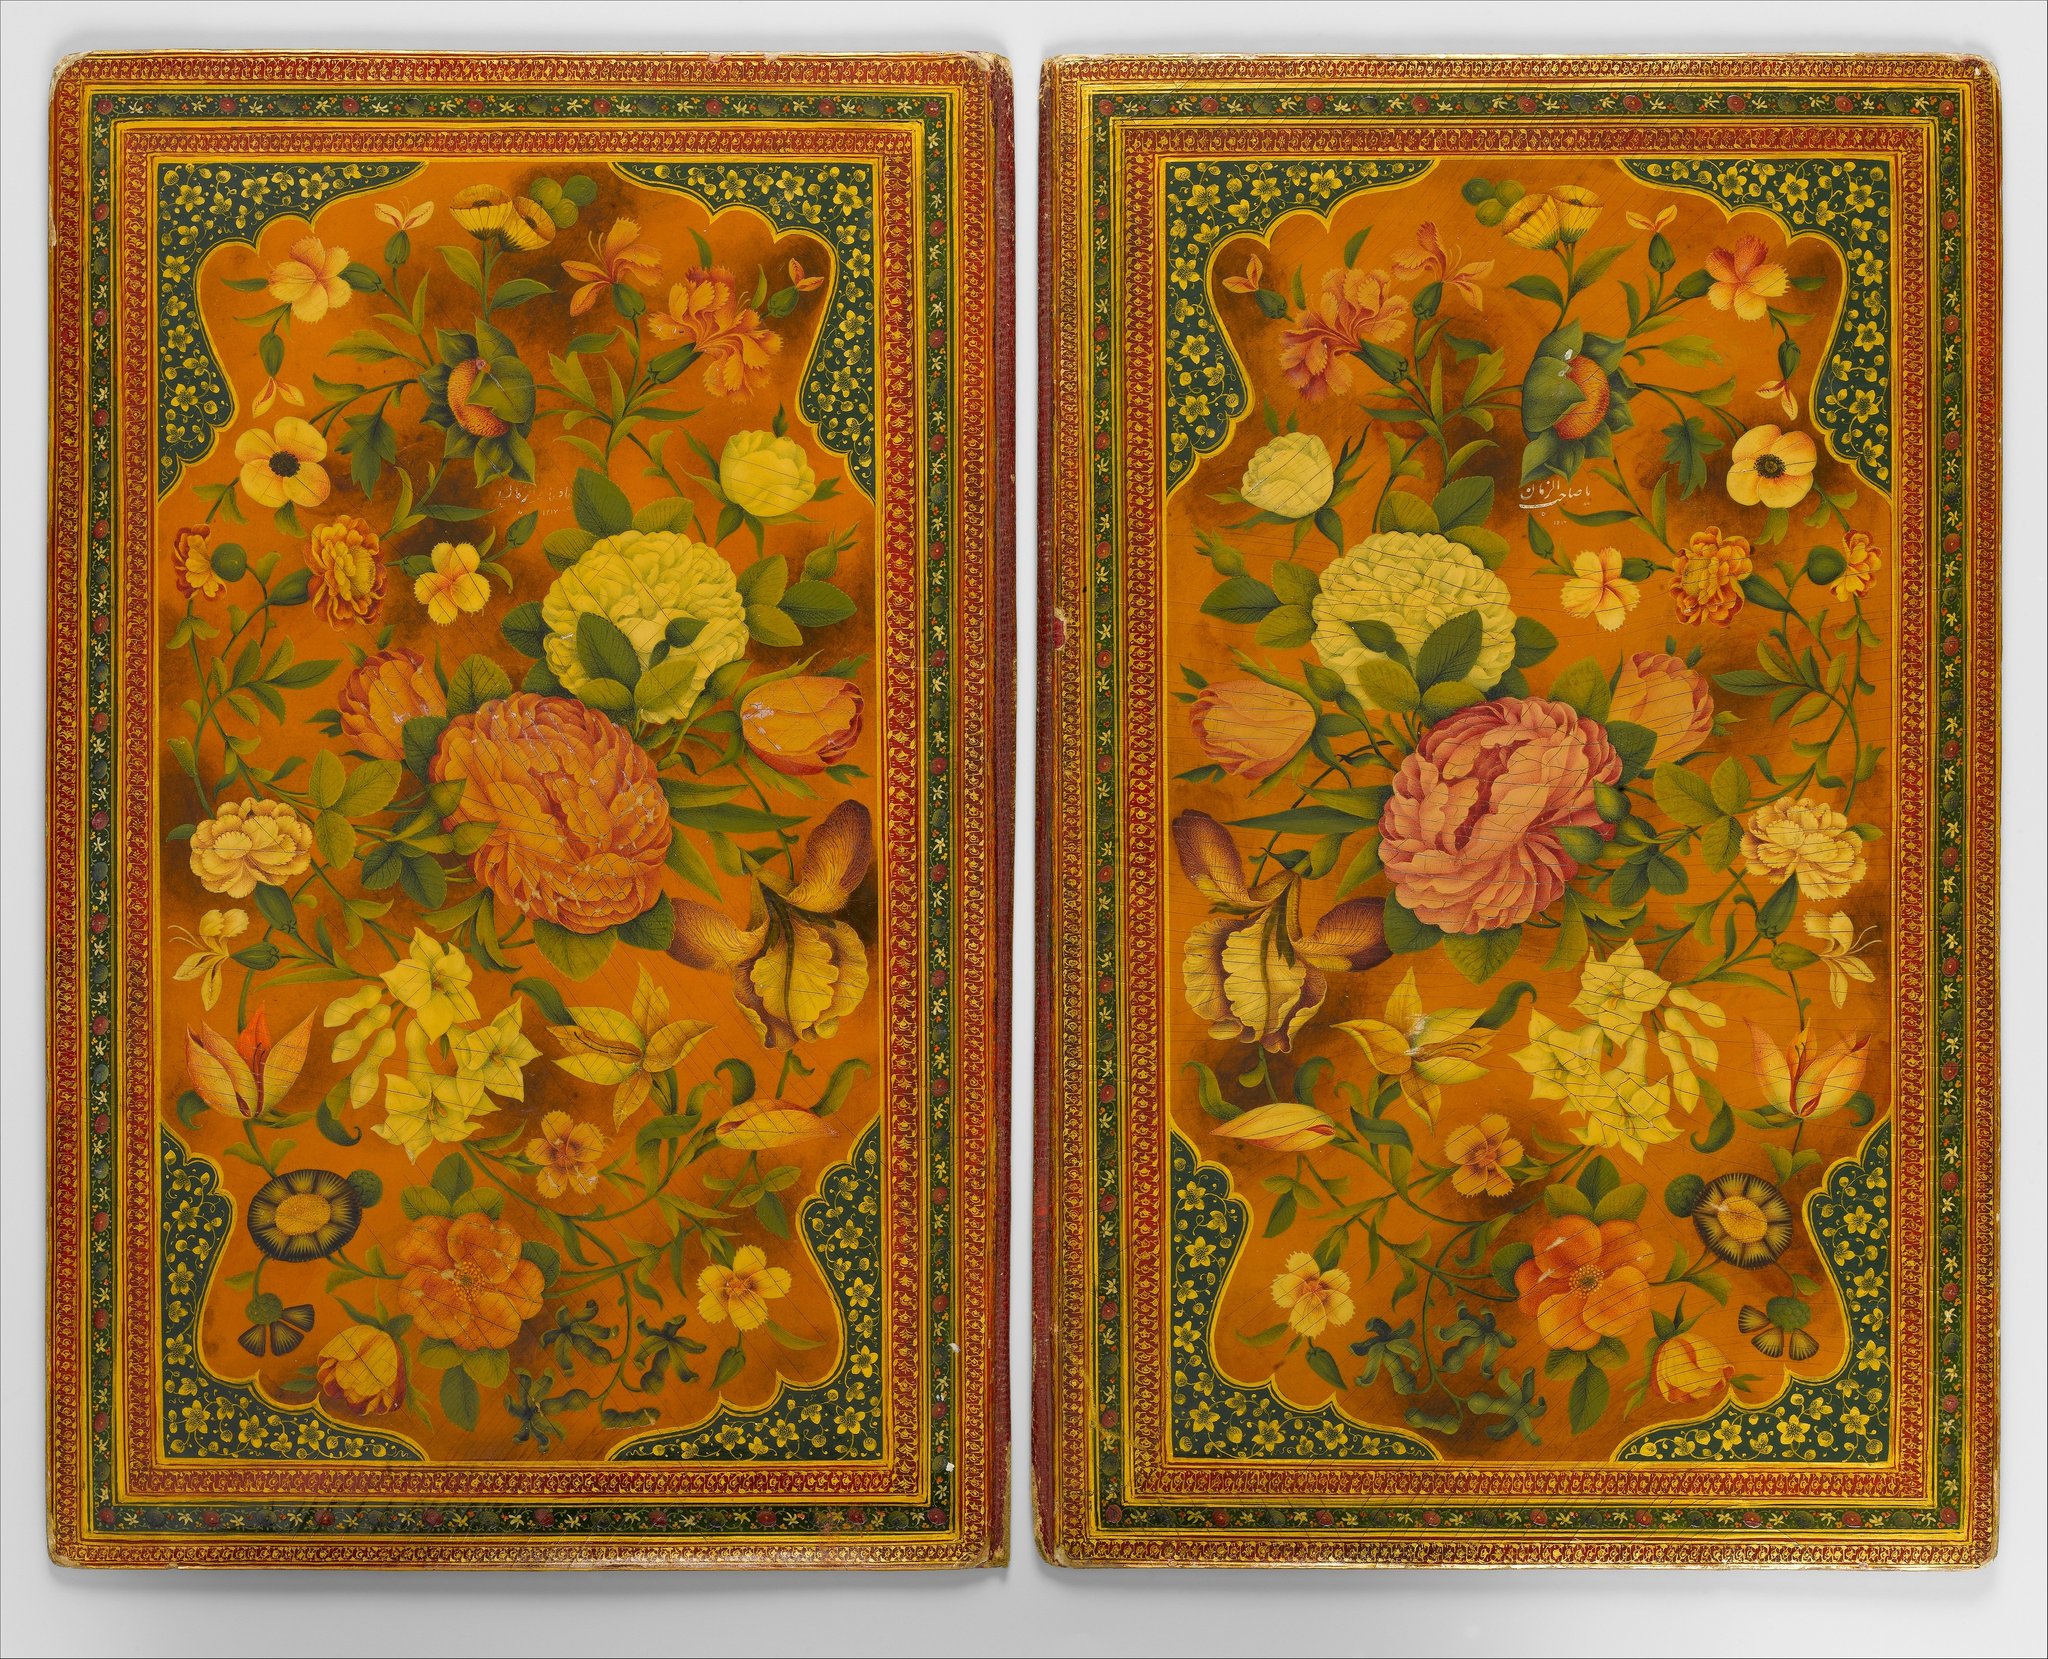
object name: album cover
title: Lacquer Covers of the Davis Album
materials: gold, paper, watercolor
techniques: lacquer, painting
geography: iran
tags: flowers,leaves